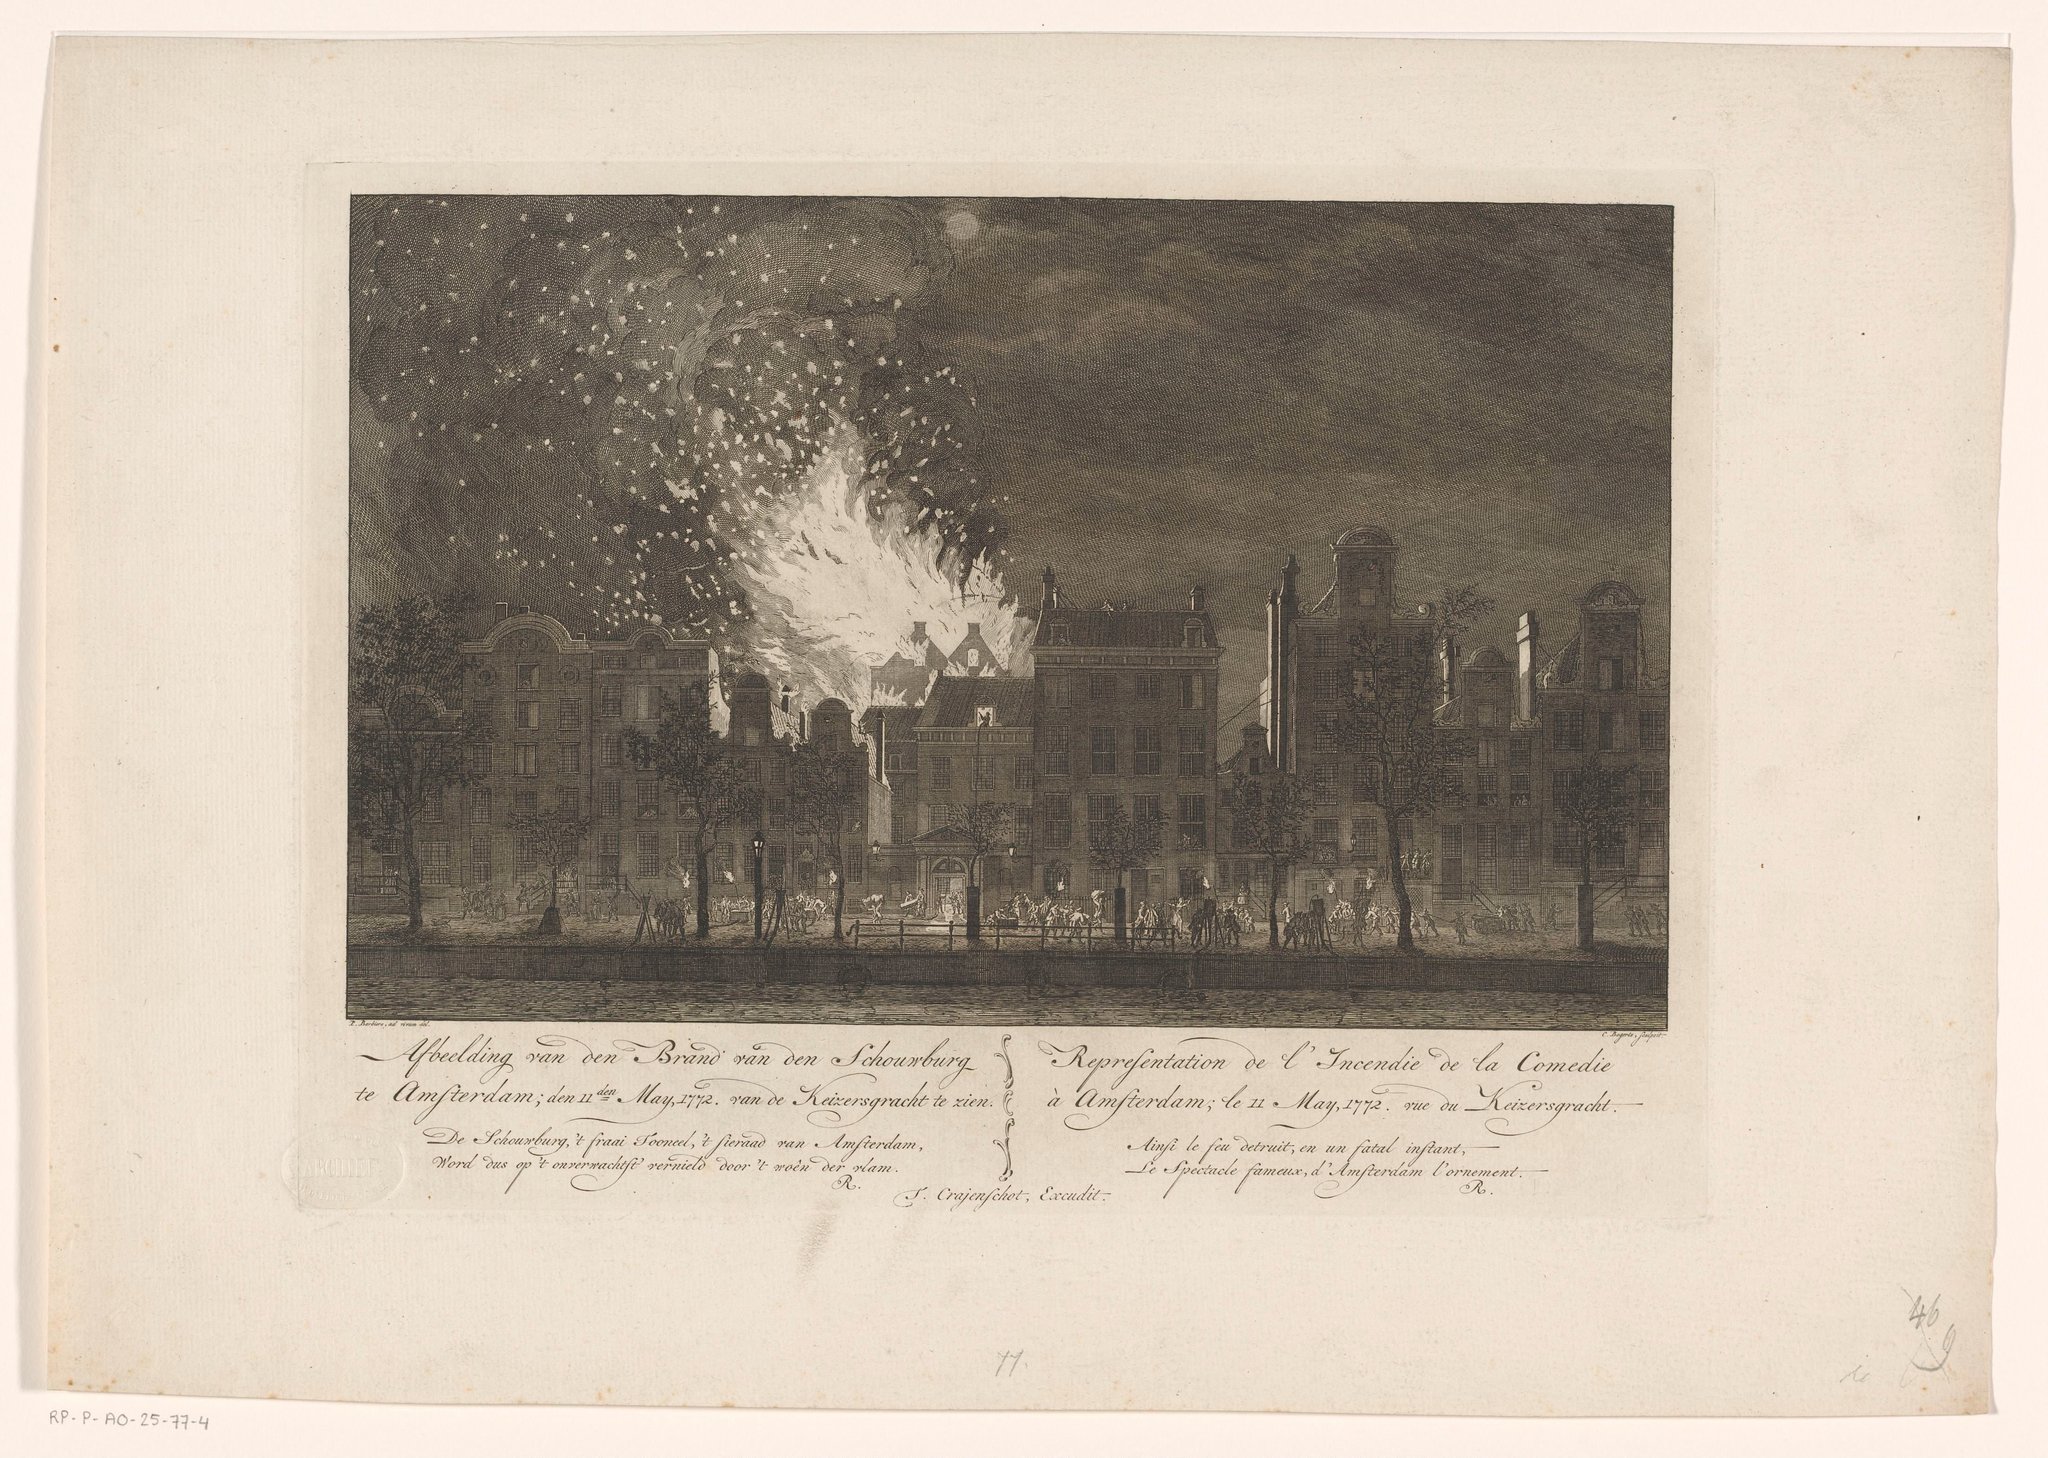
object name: print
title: Brand van de schouwburg aan de Keizersgracht te Amsterdam gezien vanaf de overzijde, 1772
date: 1772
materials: paper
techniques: engraving, etching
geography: amsterdam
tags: on fire, ablaze, theatre, theatrical performance, theatre (building), fire-fighting, rescue from fire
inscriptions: check stamp: ‘Archief Ministerie van Oorlog Afdeeling Genie’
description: Gezicht op de laaiende brand in de Amsterdamse Schouwburg op 11 mei 1772, gezien vanaf de overzijde van de Keizersgracht. De brandweer brengt brandspuitpompen in gereedheid. Uit de schouwburg worden kisten en koffers gedragen. Onder de voorstelling de titel en een tweeregelig vers in het Nederlands (links) en Frans (rechts). Onderdeel van een serie van vier prenten met titelprent over de brand in de Amsterdamse Schouwburg.